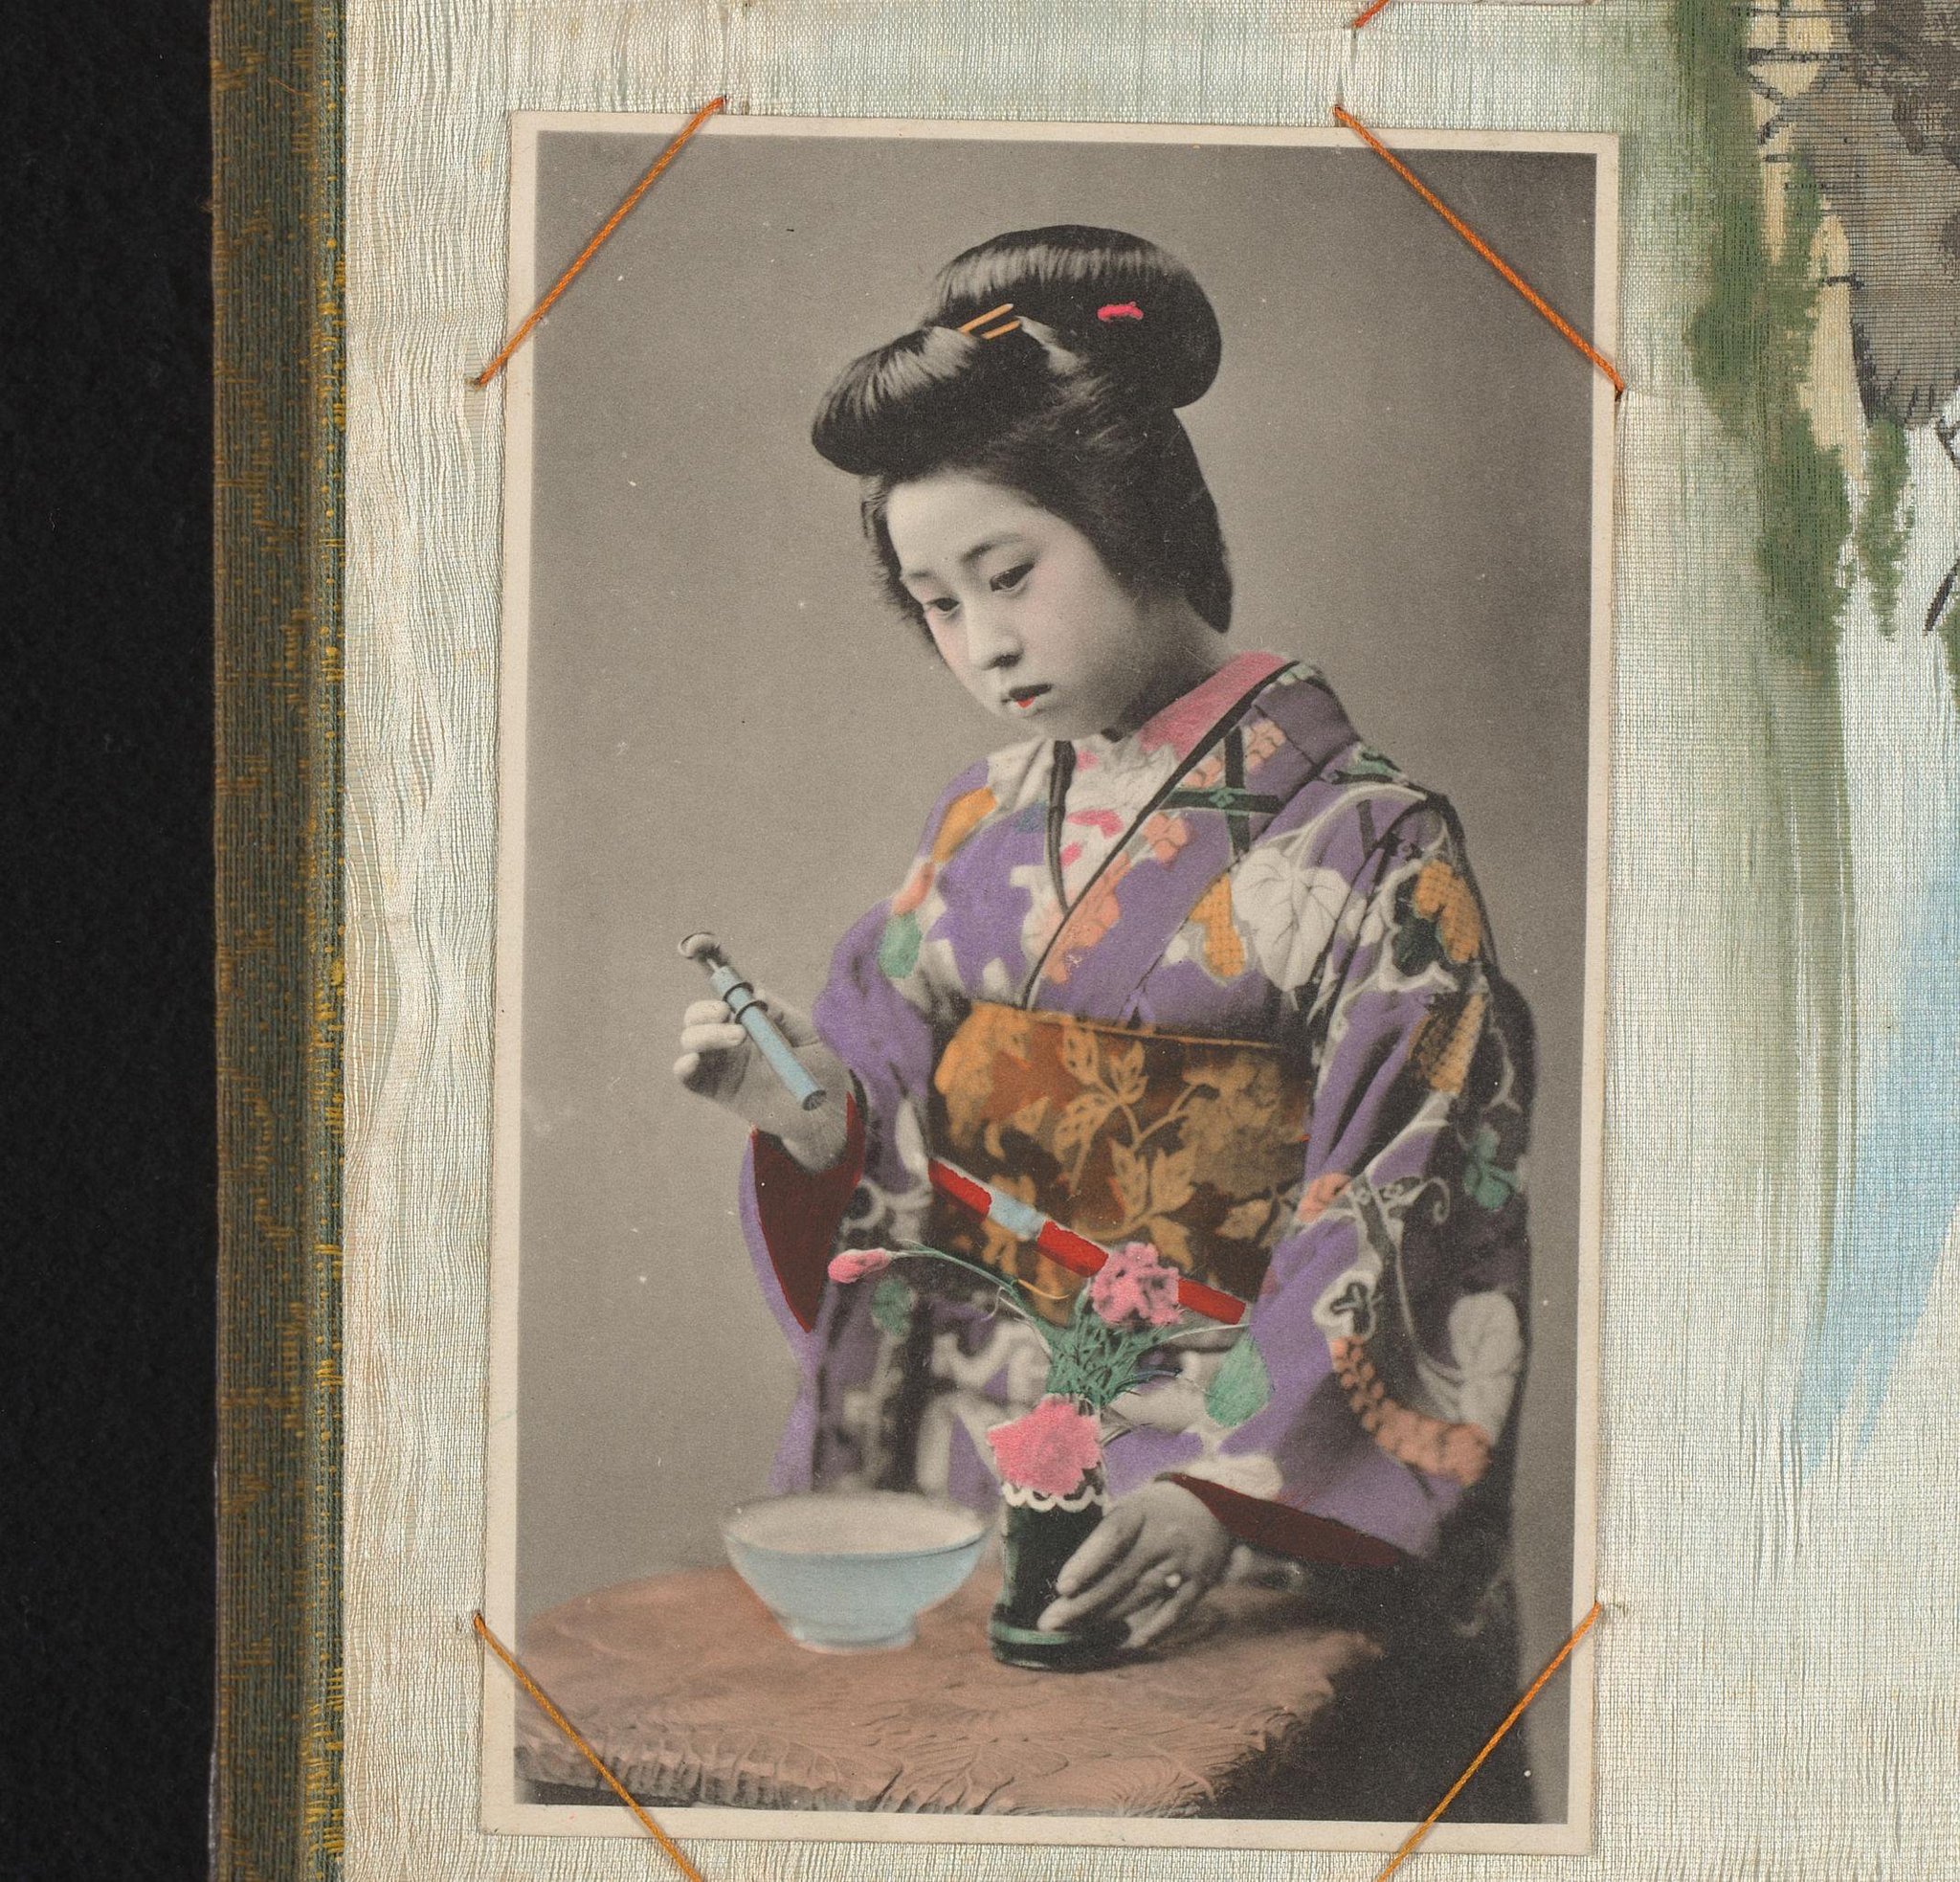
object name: photomechanical print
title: Japanse vrouw in paarse kimono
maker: Anonymous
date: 1900-1920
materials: paper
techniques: photograph, hand coloring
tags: flowers, historical persons - bb - woman, folk costume, regional costume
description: Deze prent maakt deel uit van een album.